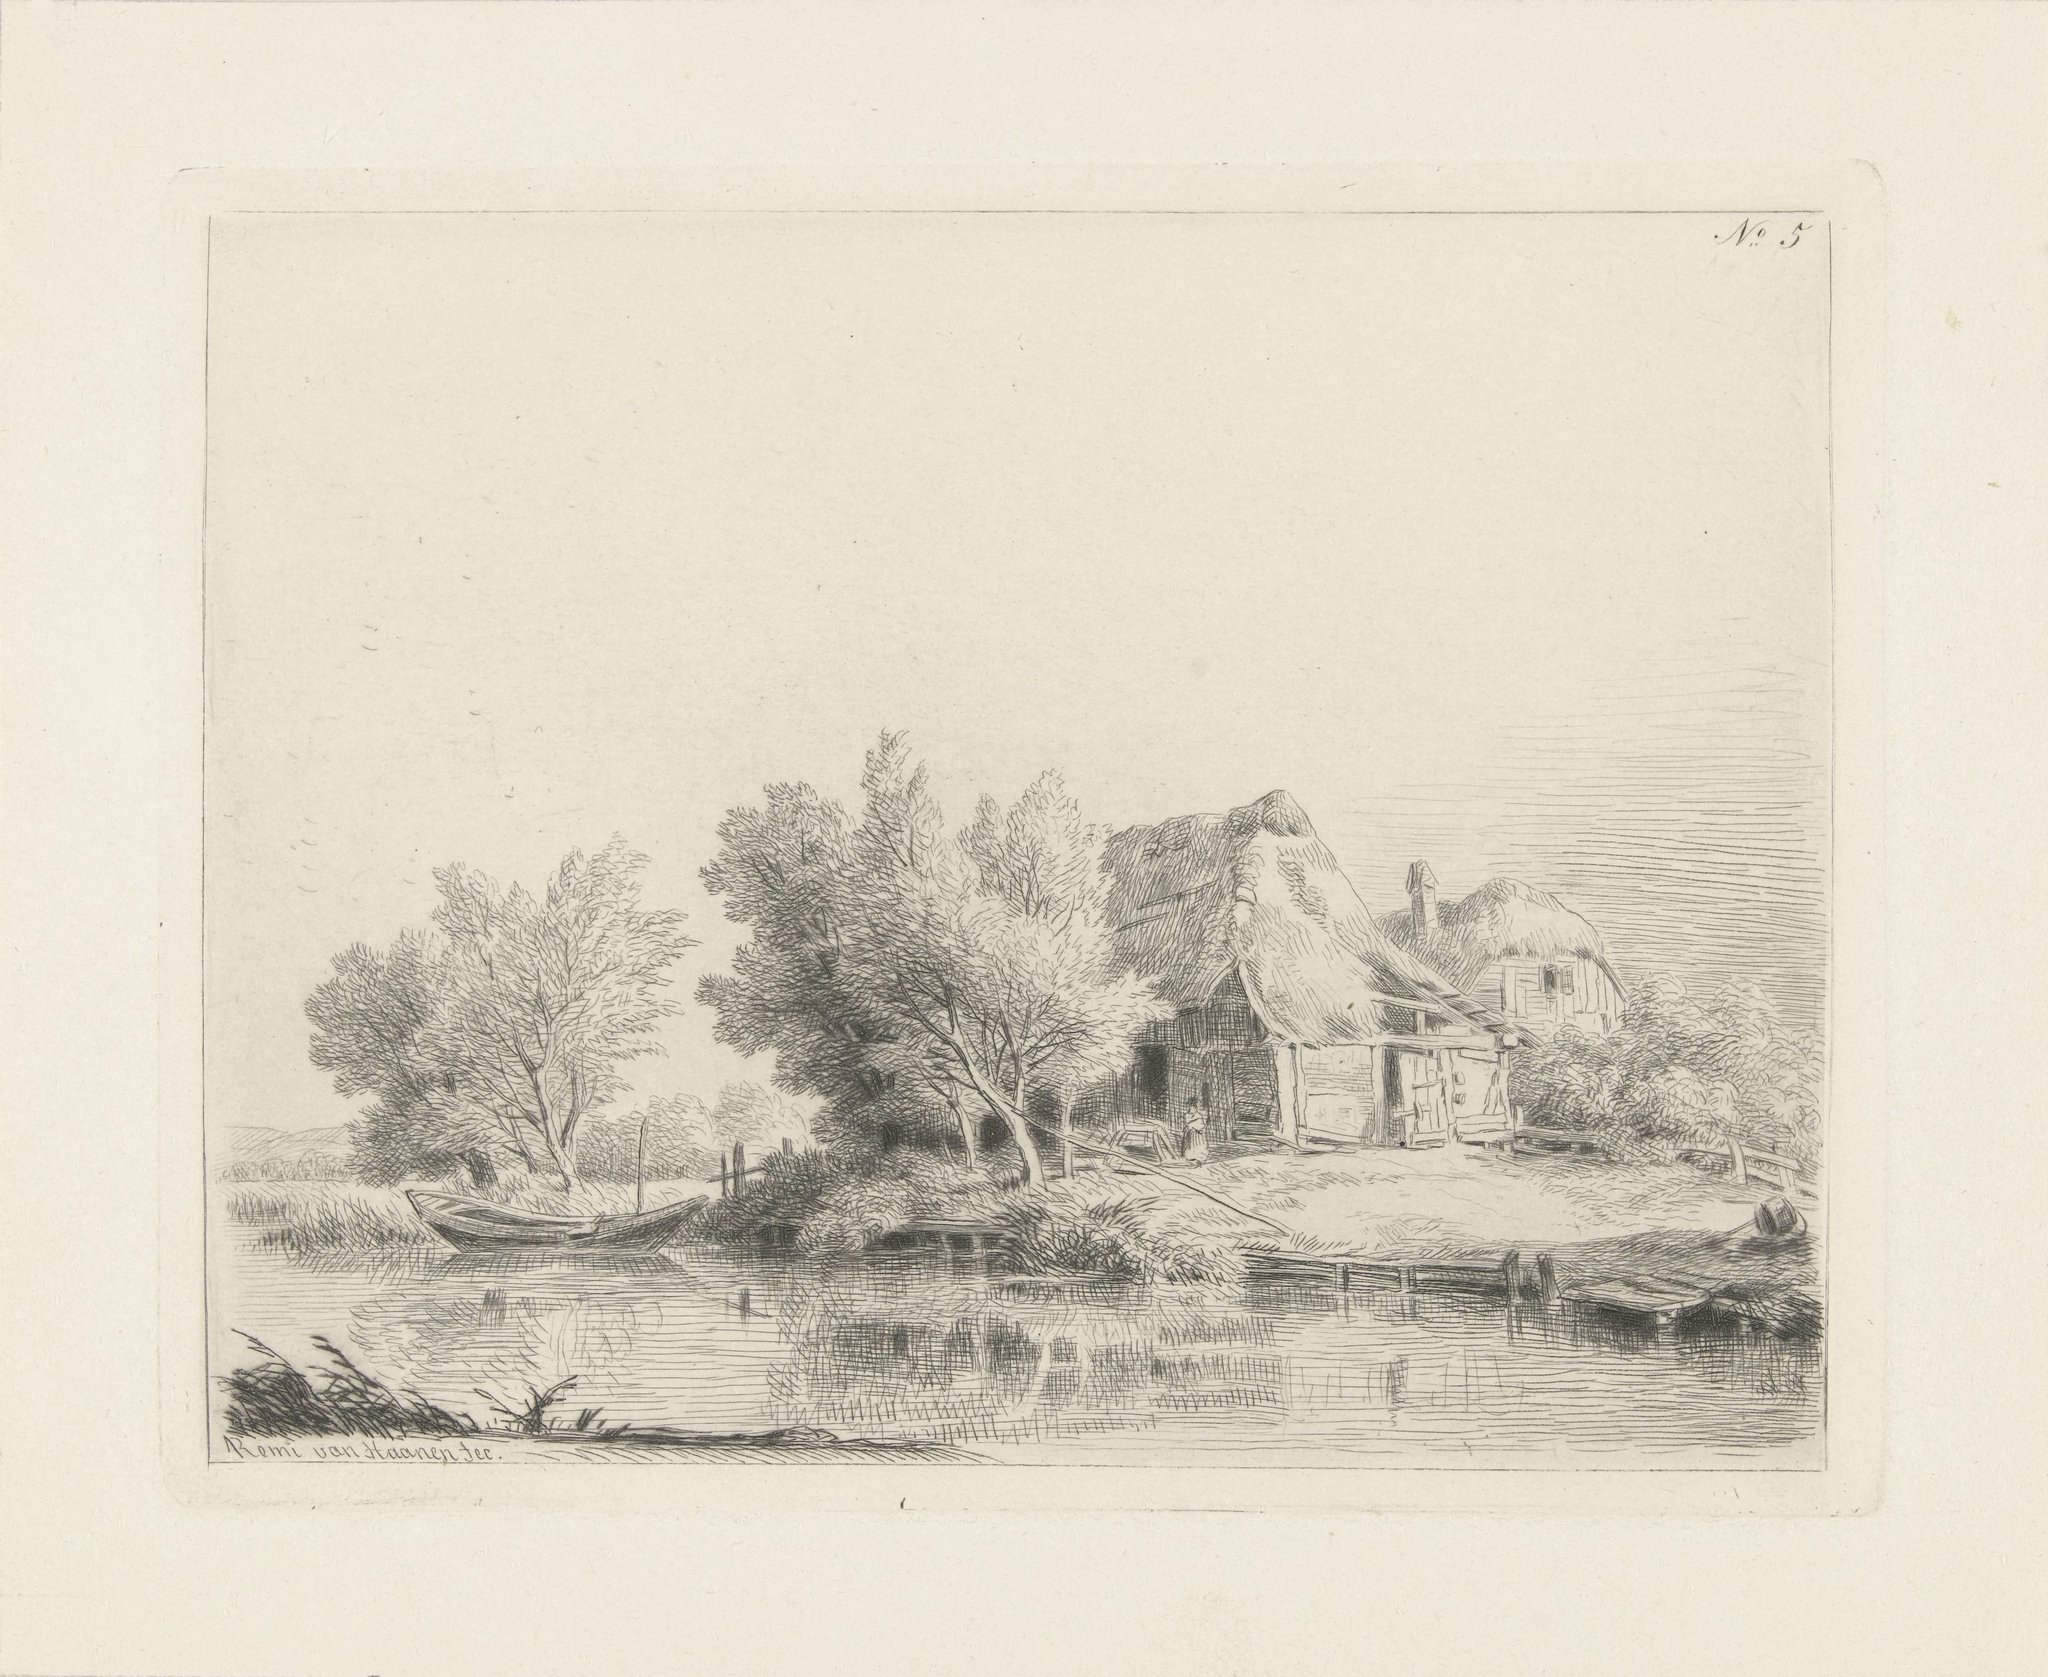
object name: print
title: Vrouw bij een boerderij aan een plas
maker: remigius adrianus haanen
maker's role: draughtsman, painter, print maker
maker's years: 1812-1894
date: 1827-1888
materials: paper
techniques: drypoint, etching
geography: austria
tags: farm or solitary house in landscape (+ city(-scape) with figures, staffage)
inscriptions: collector's mark: Lugt 2228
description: Deze prent is genummerd No.5 rechtsboven en zou om die reden een prent kunnen zijn uit de serie van zes waarvan het titelblad is beschreven onder RP-P-OB-55.650.